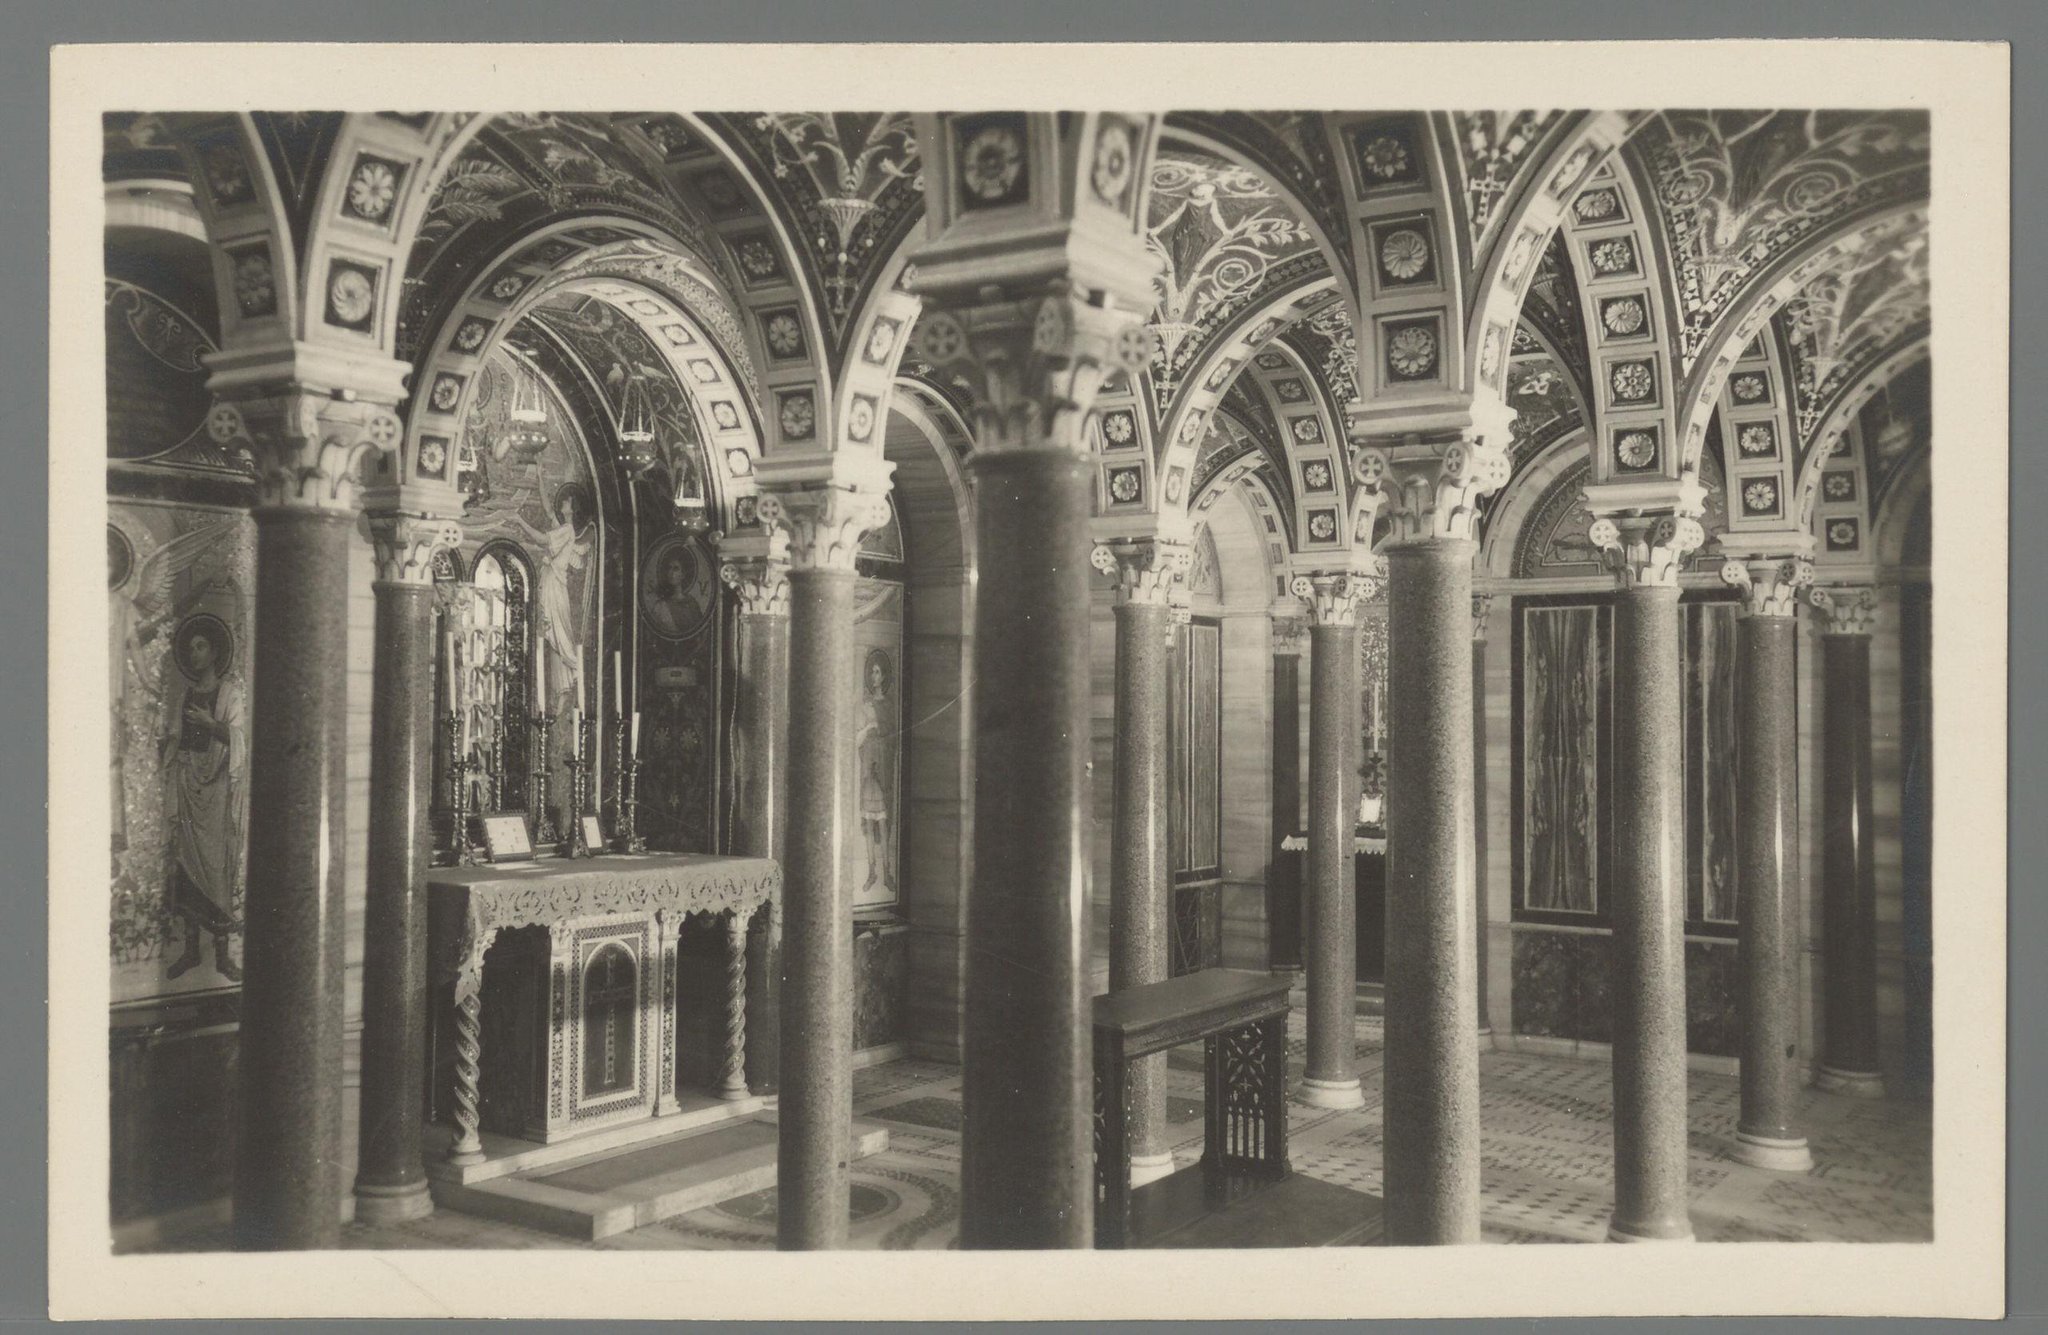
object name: ansichtkaart, prentbriefkaart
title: Roma. Cripta nella Chiesa di S. Cecilia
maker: Anonymous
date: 1931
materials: photographic support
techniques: photography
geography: rome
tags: parts of church interior (crypt)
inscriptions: date